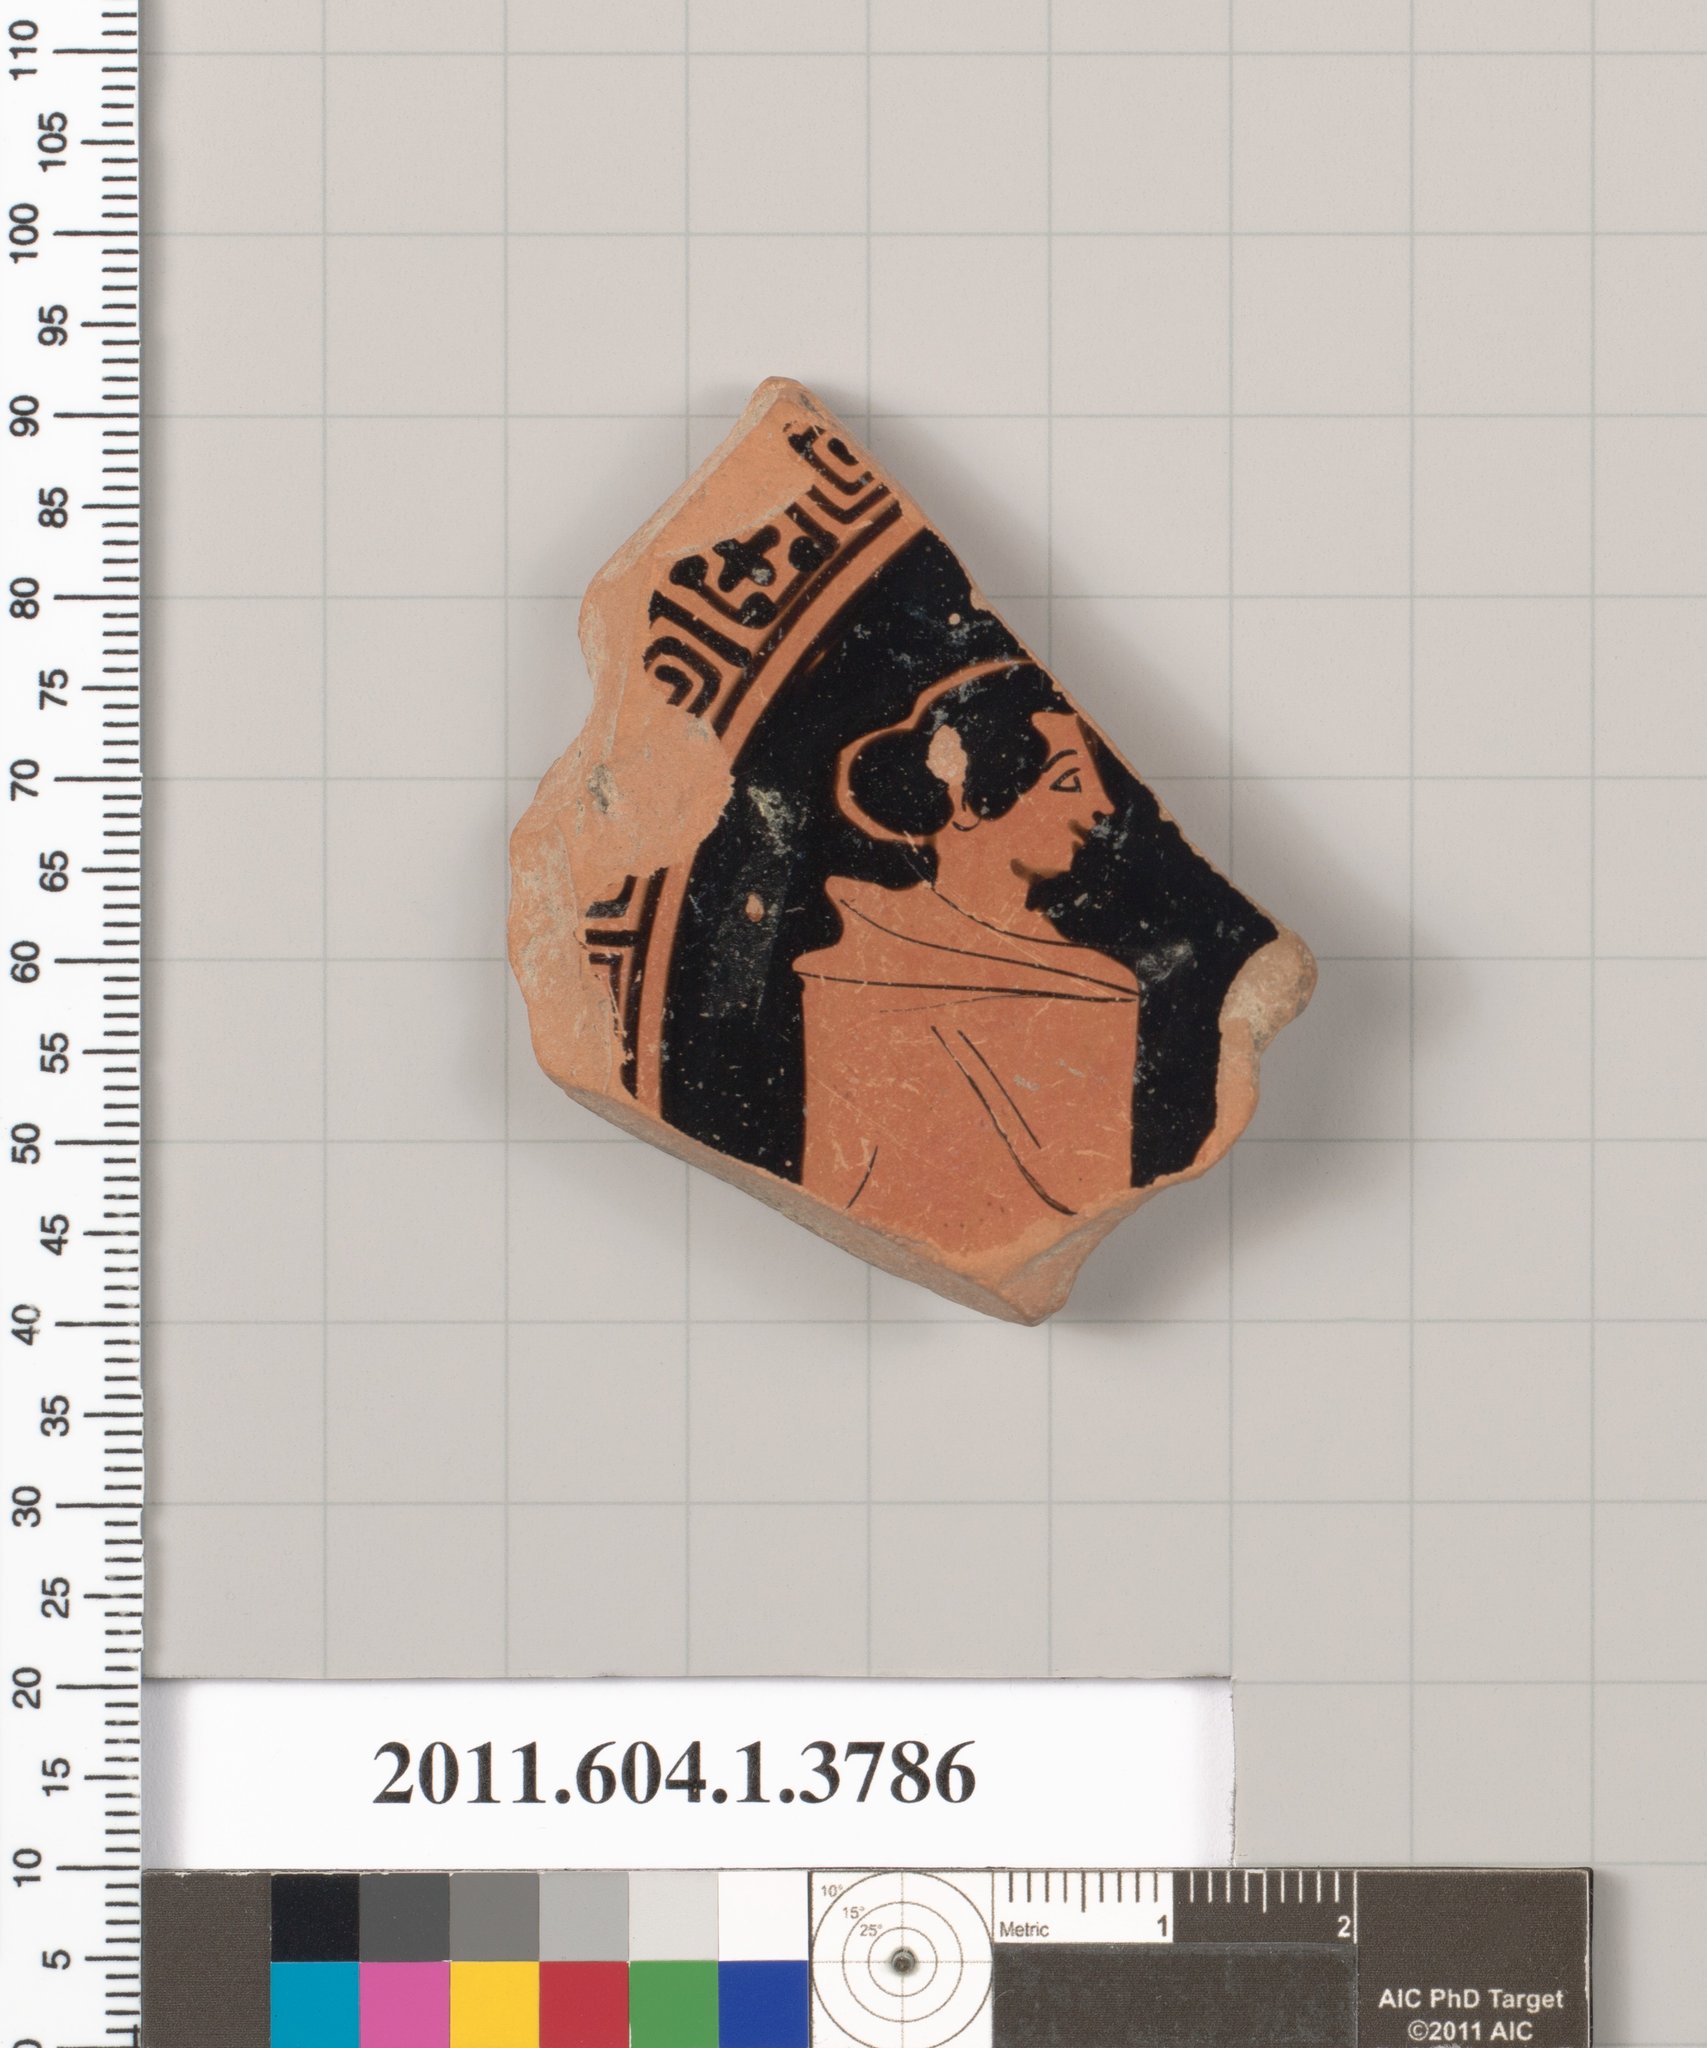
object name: kylix fragment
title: Terracotta fragment of a kylix (drinking cup)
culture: greek, attic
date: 475-451 BCE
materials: terracotta